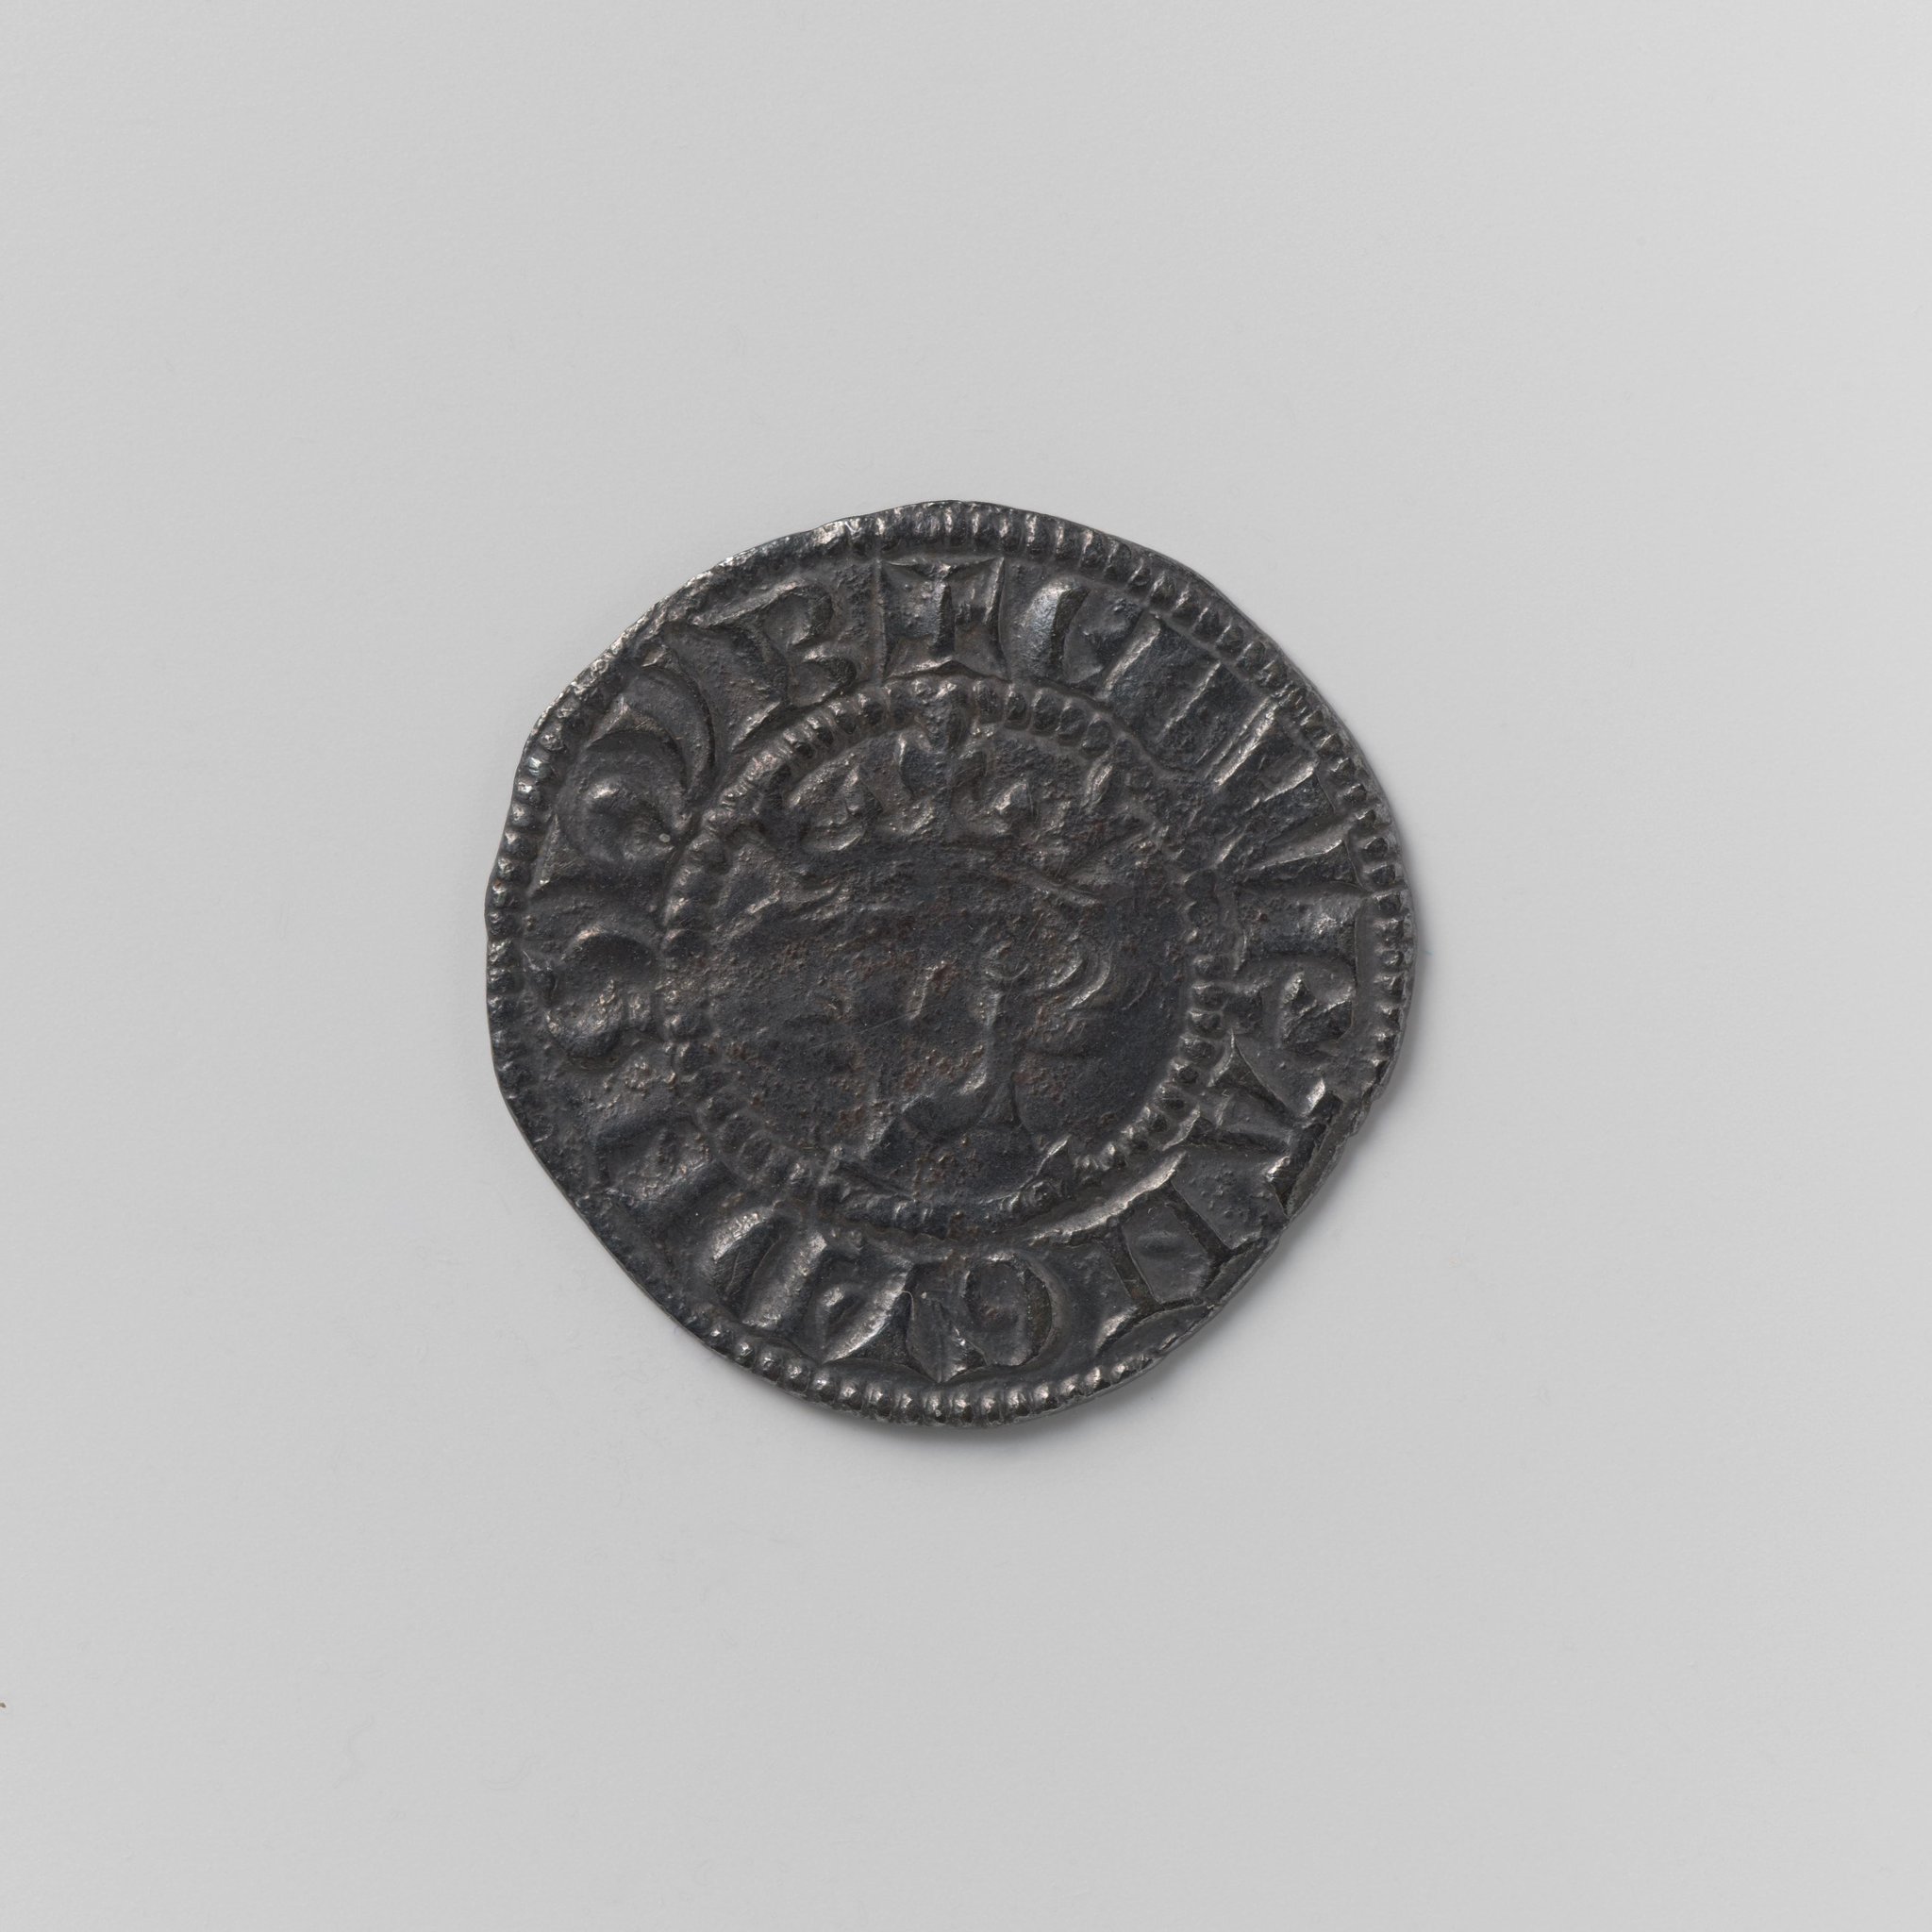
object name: coin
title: Engeland, Edward I/II/III, penny, 1272-1377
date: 1279-1377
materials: silver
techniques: striking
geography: london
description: Zilveren munt. Voorzijde: aanziend gekroond hoofd. Keerzijde: lang enkellijnig gevoet kruis.